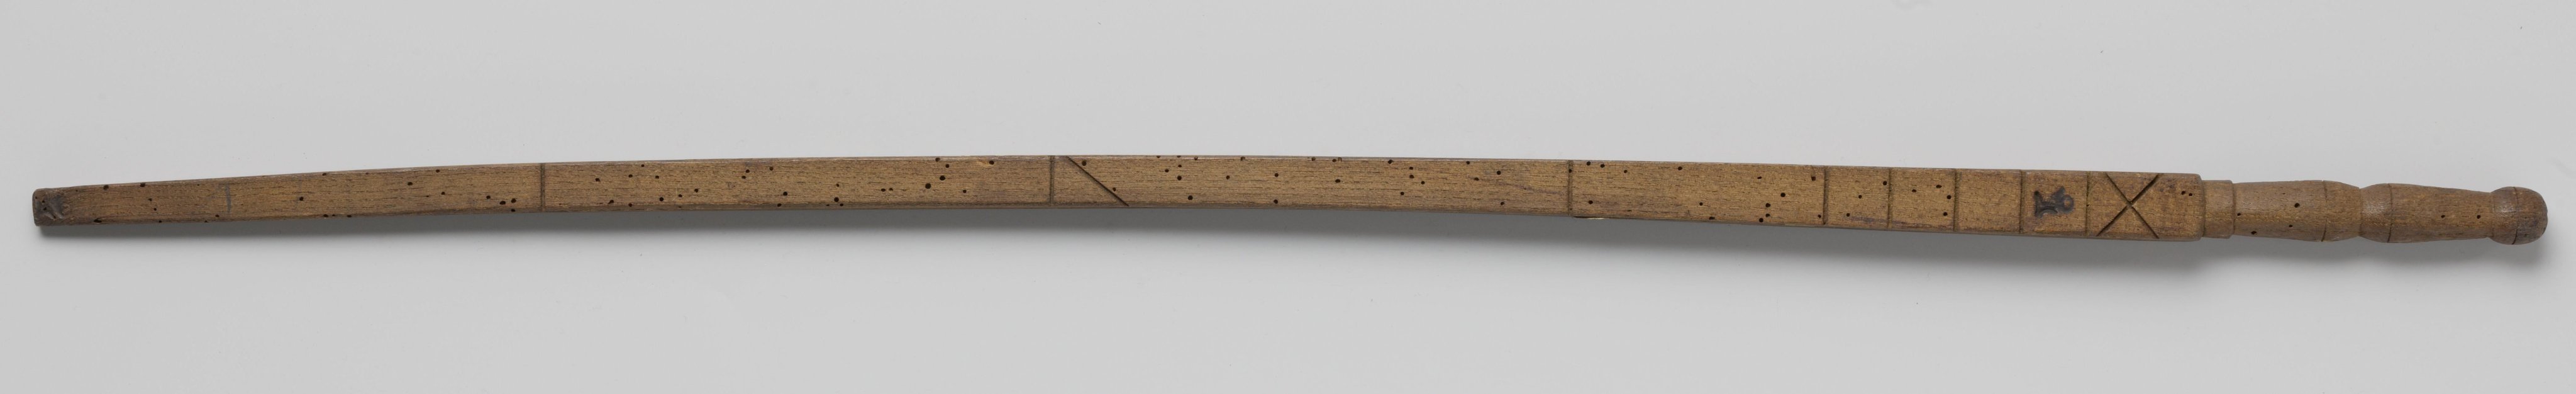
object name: ellemaat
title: Ellemaat met handvat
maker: Anonymous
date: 1797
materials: wood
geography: netherlands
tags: netherlands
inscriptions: inscription: ‘97’, inscription: ‘IB’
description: Lengtemaat van 1 el met handvat. V.z.v. stempel.